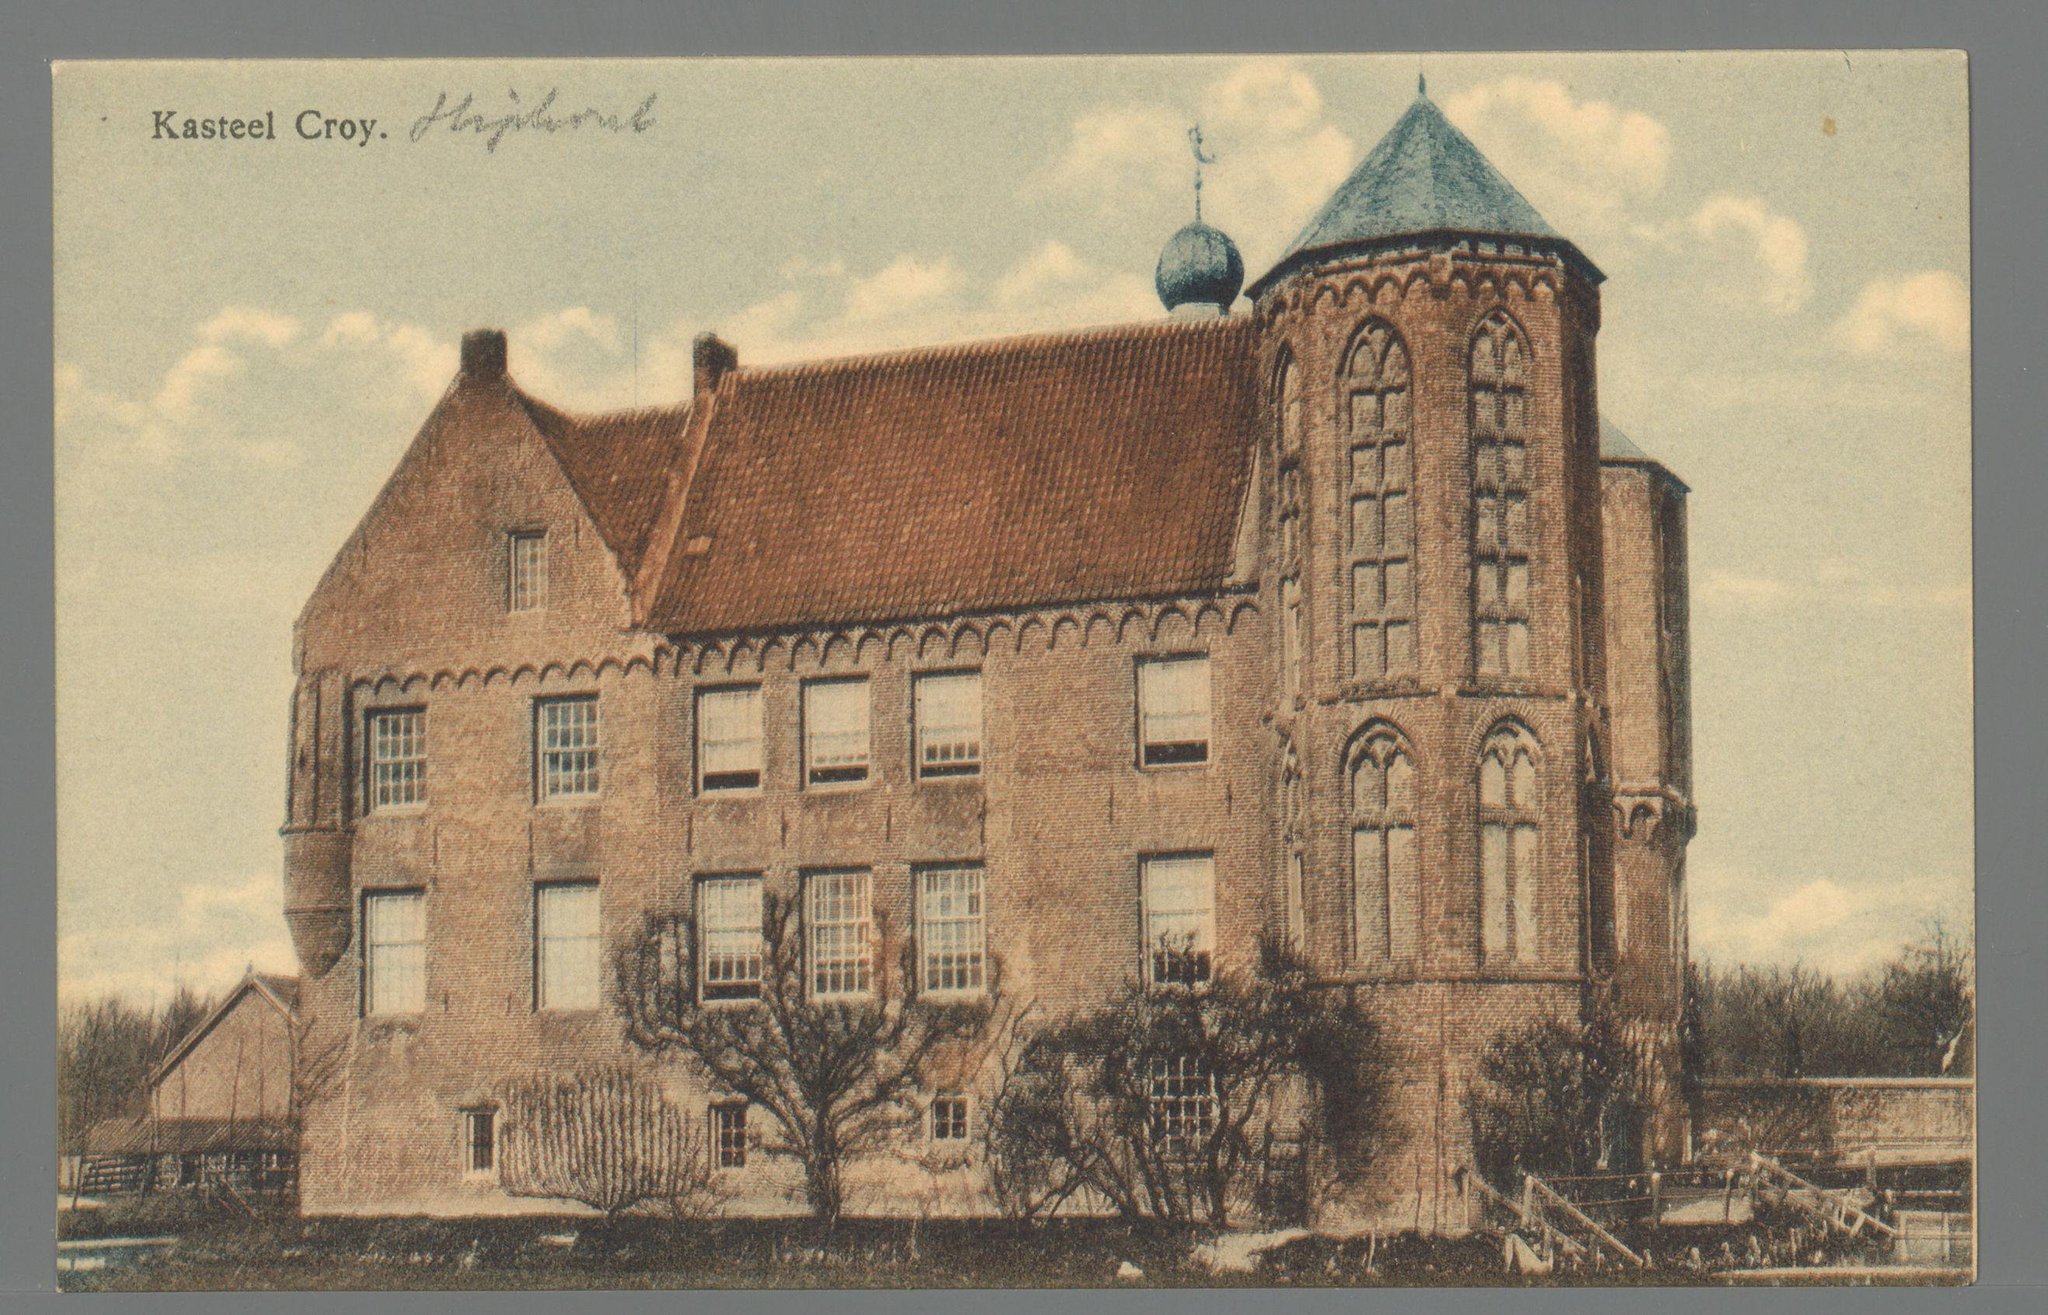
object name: photomechanical print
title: Kasteel Croy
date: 1905-1930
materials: cardboard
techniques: collotype process, writing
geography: amsterdam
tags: castle